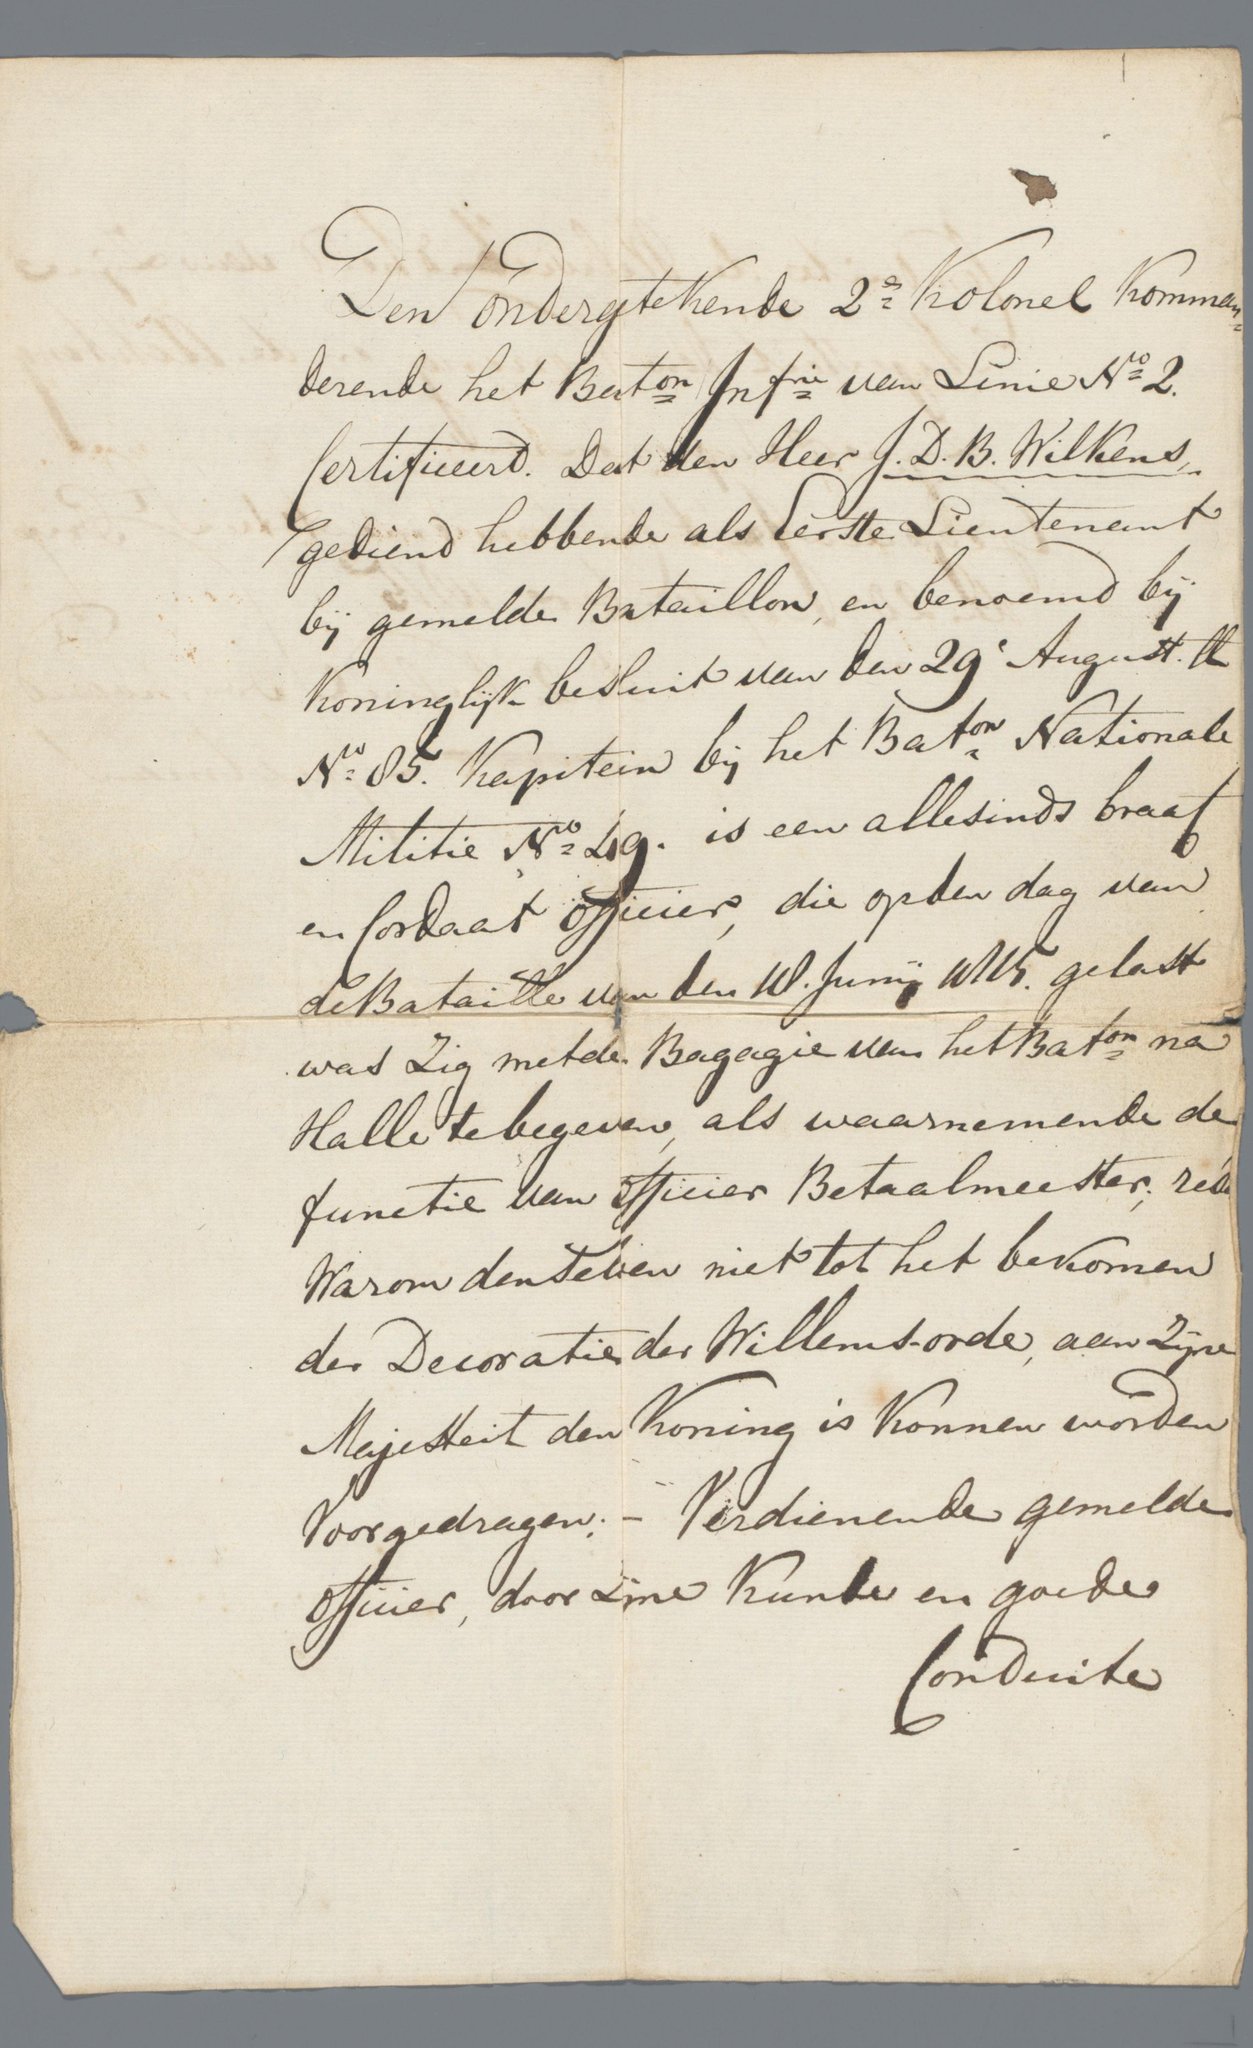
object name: letter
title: Conduite voor J.D.B. Wilkens, 20 september 1815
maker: Anonymous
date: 1815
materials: ink, paper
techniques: handwriting, pen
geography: netherlands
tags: amsterdam, military service, netherlands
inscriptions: number: ‘11198’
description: Onderdeel van een groep van documenten betreffende de staat van dienst, benoemingen, enz. van Luitenant Kolonel van de Infanterie J.D.B. Wilkens. Behorende bij de schenking van het geschilderde portret.